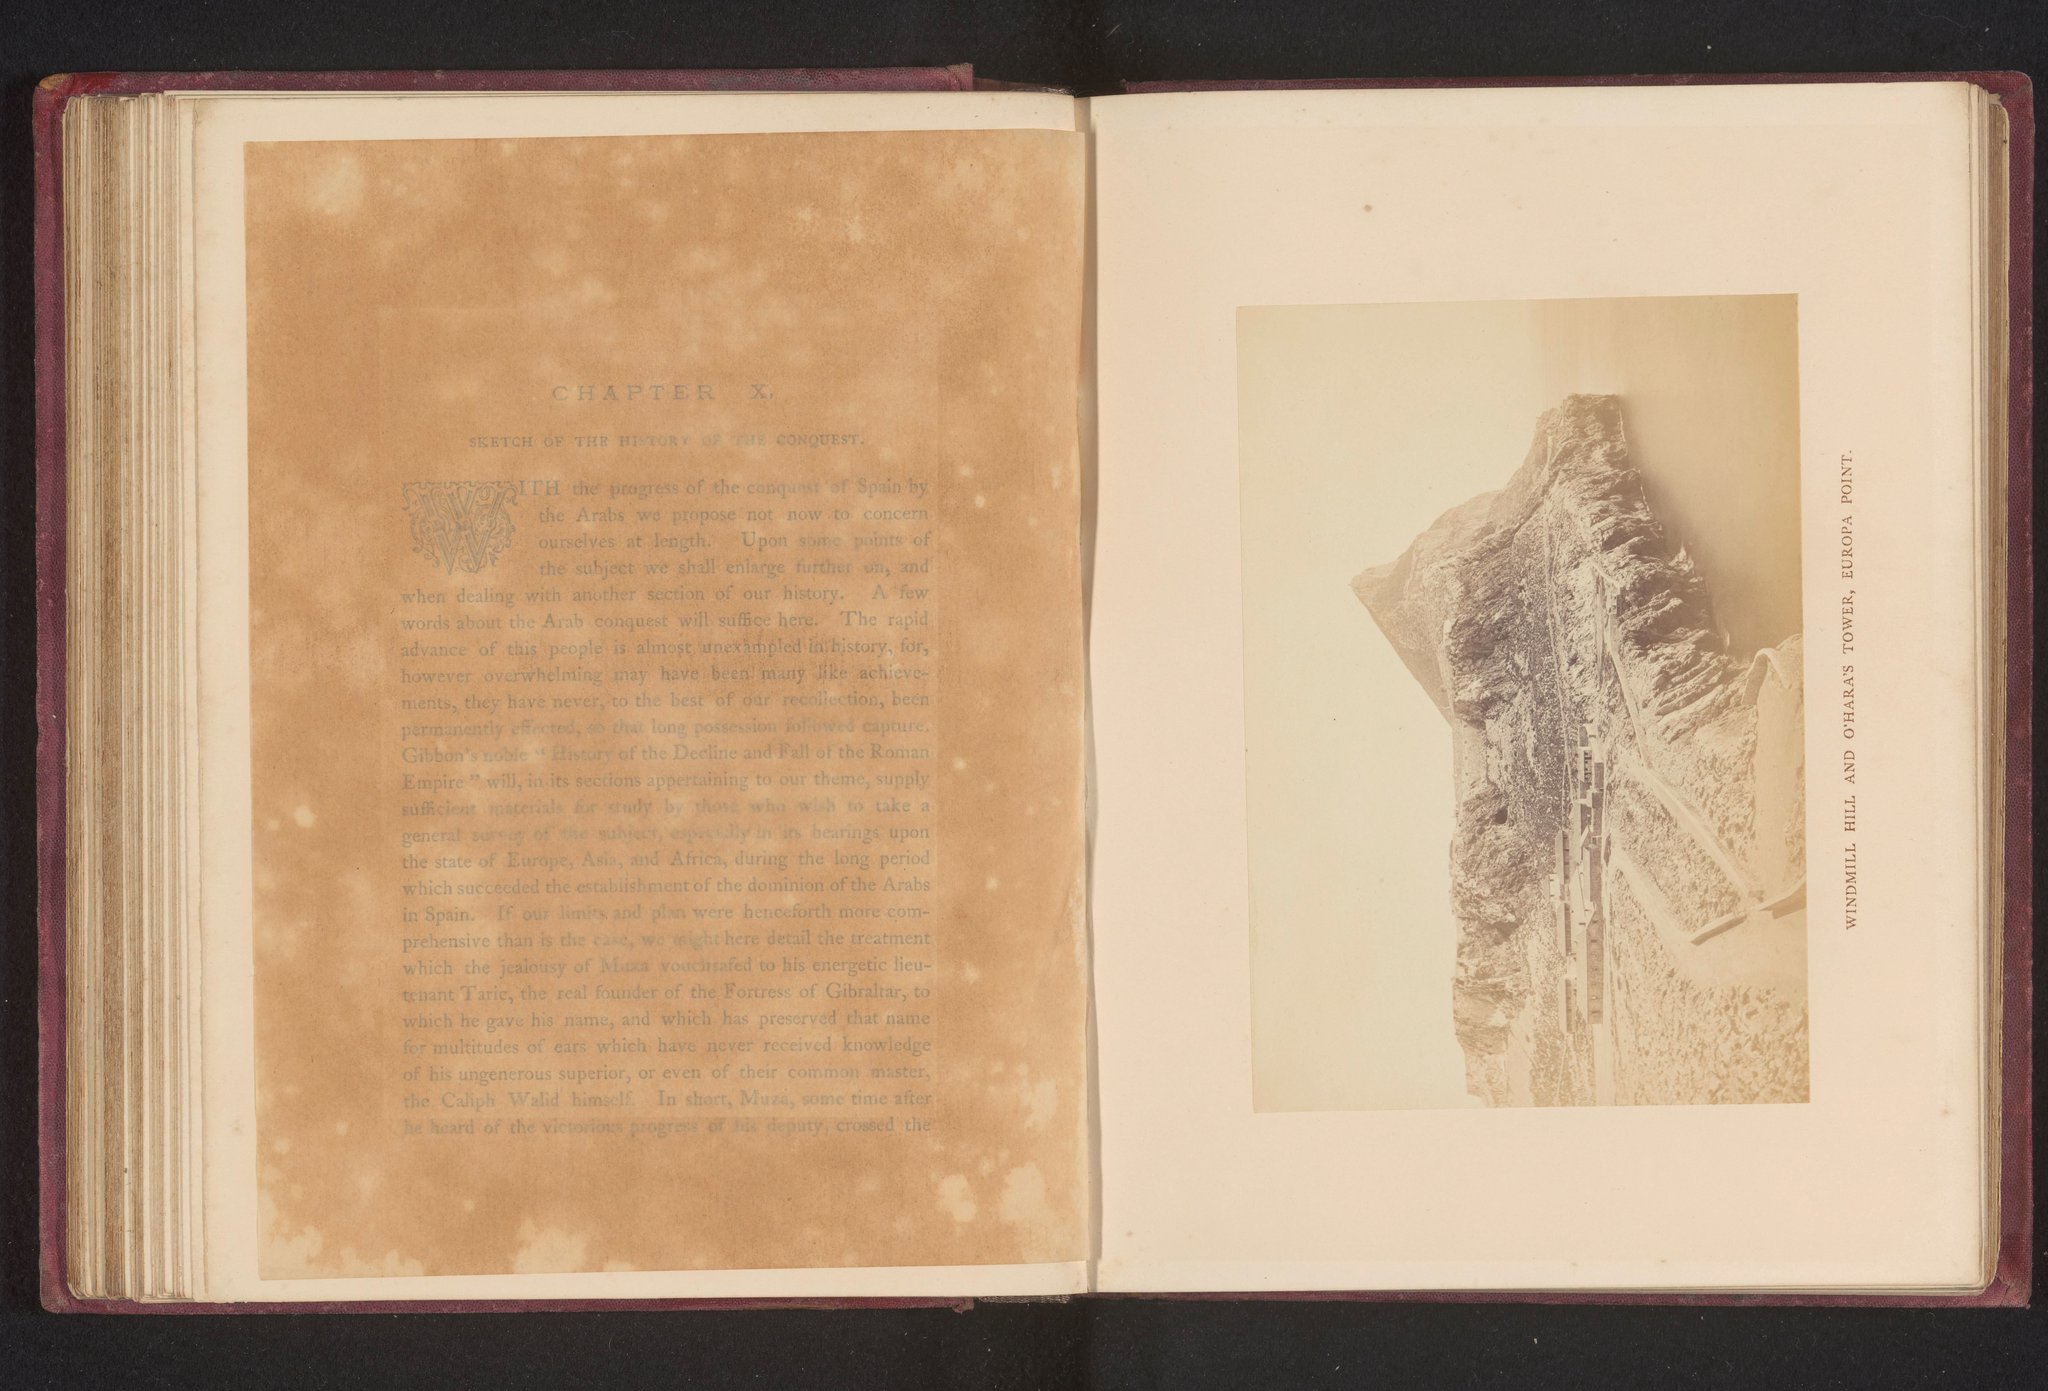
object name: page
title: Windmill Hill, and O'Hara's Tower, Europa point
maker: j.h. mann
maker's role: fotograaf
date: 1860-1870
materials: photographic support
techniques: albumen print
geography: gibraltar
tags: rock-formations